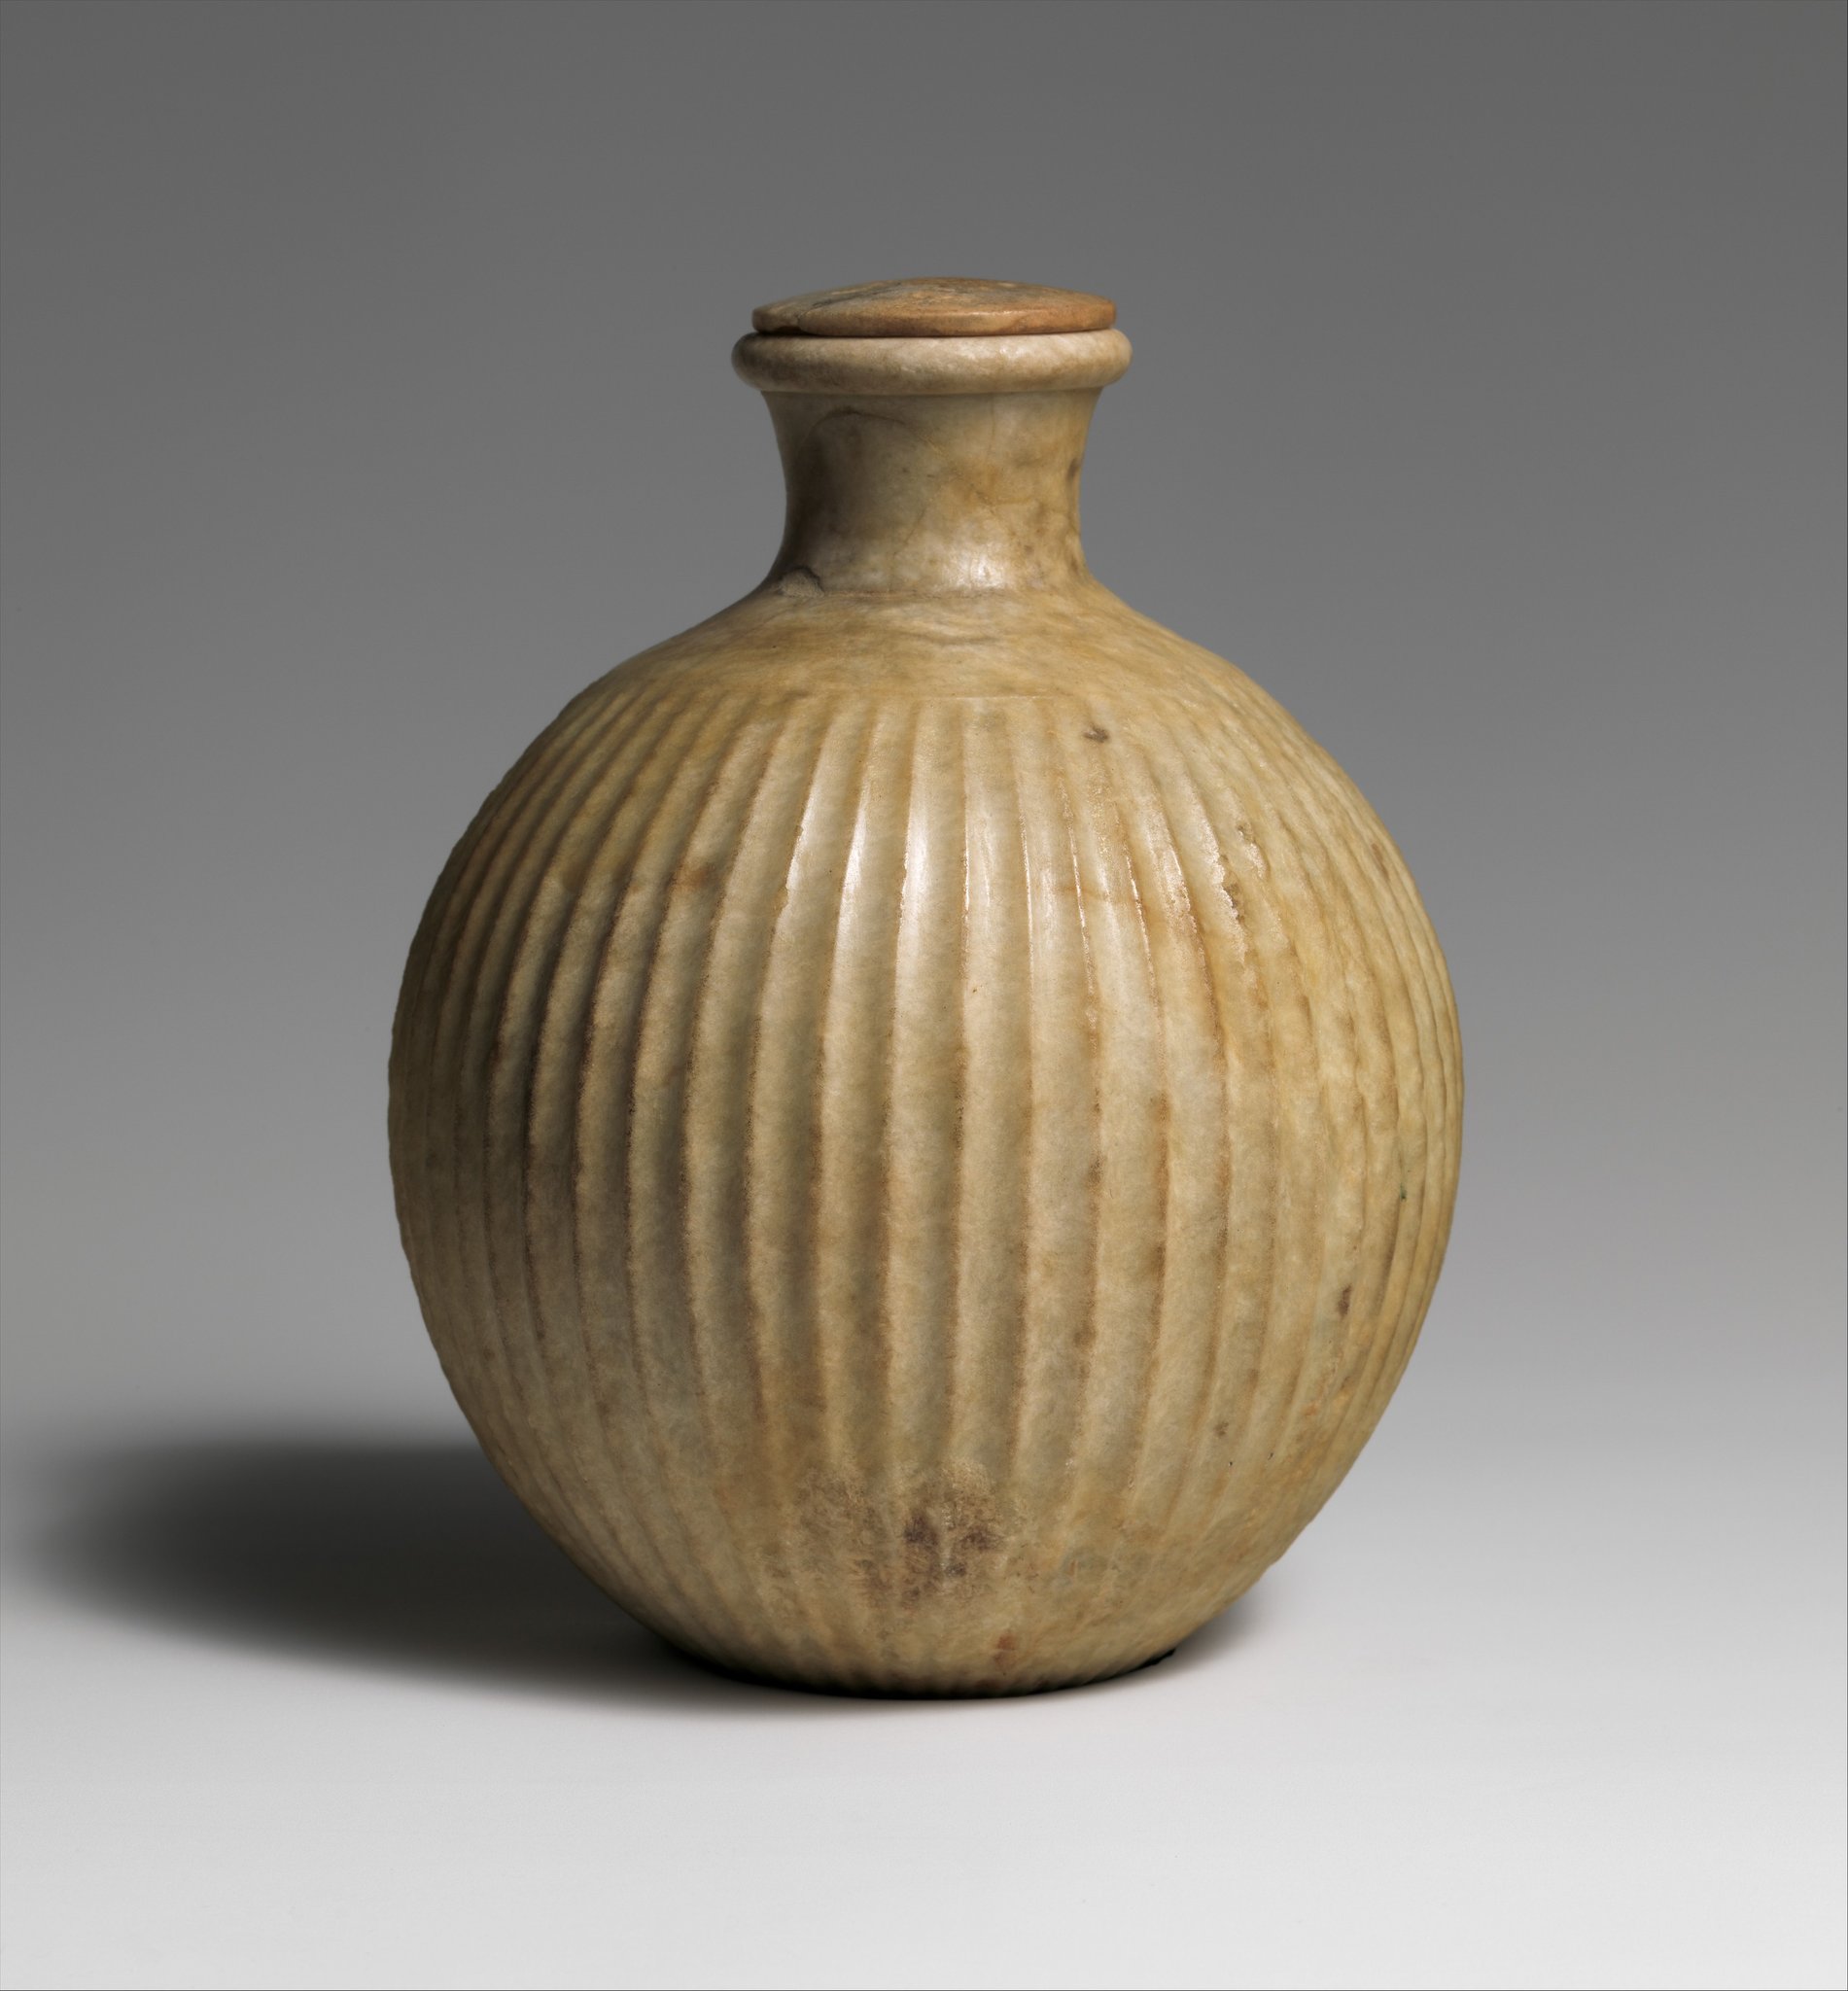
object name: bottle, fluted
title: Fluted bottle with lid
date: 1950 BCE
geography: northern upper egypt